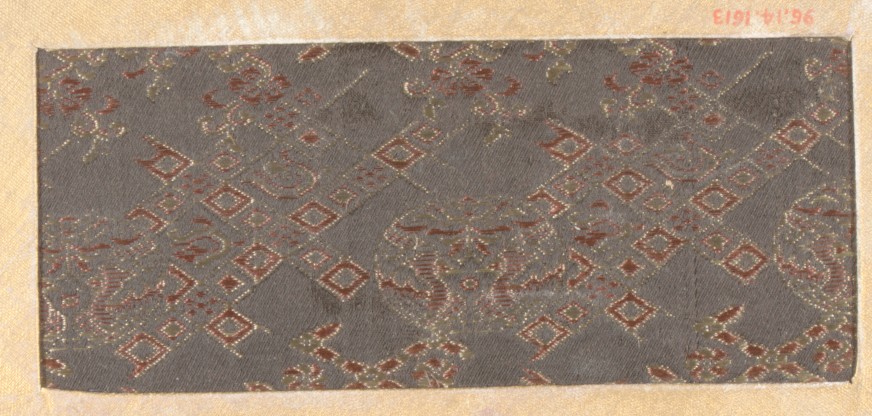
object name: piece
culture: japanese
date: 1701-1900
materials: silk